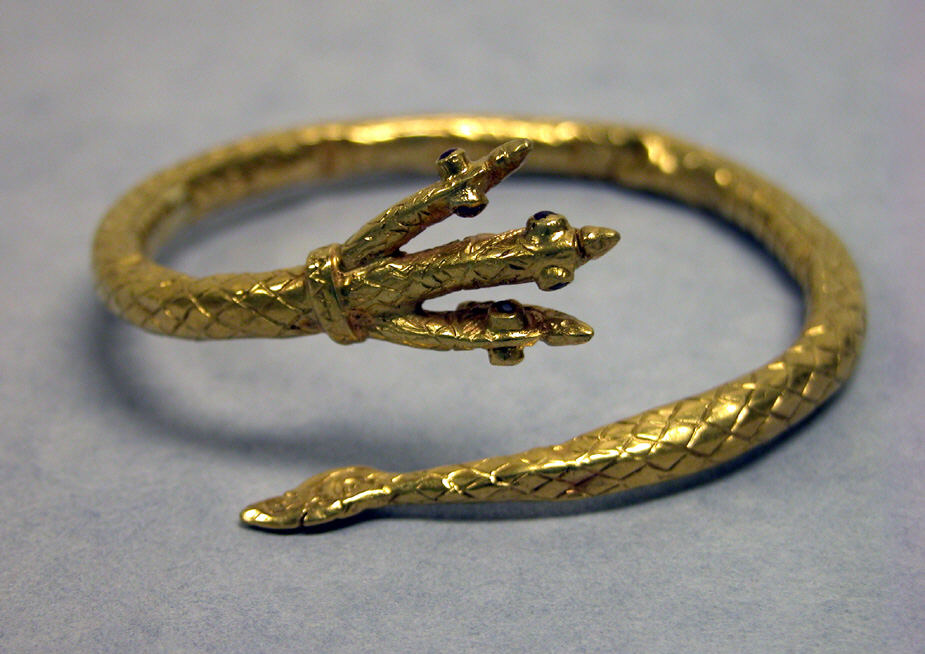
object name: bracelet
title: Bracelet with Three-Headed Snake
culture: northern thai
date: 1401-1600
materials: gold